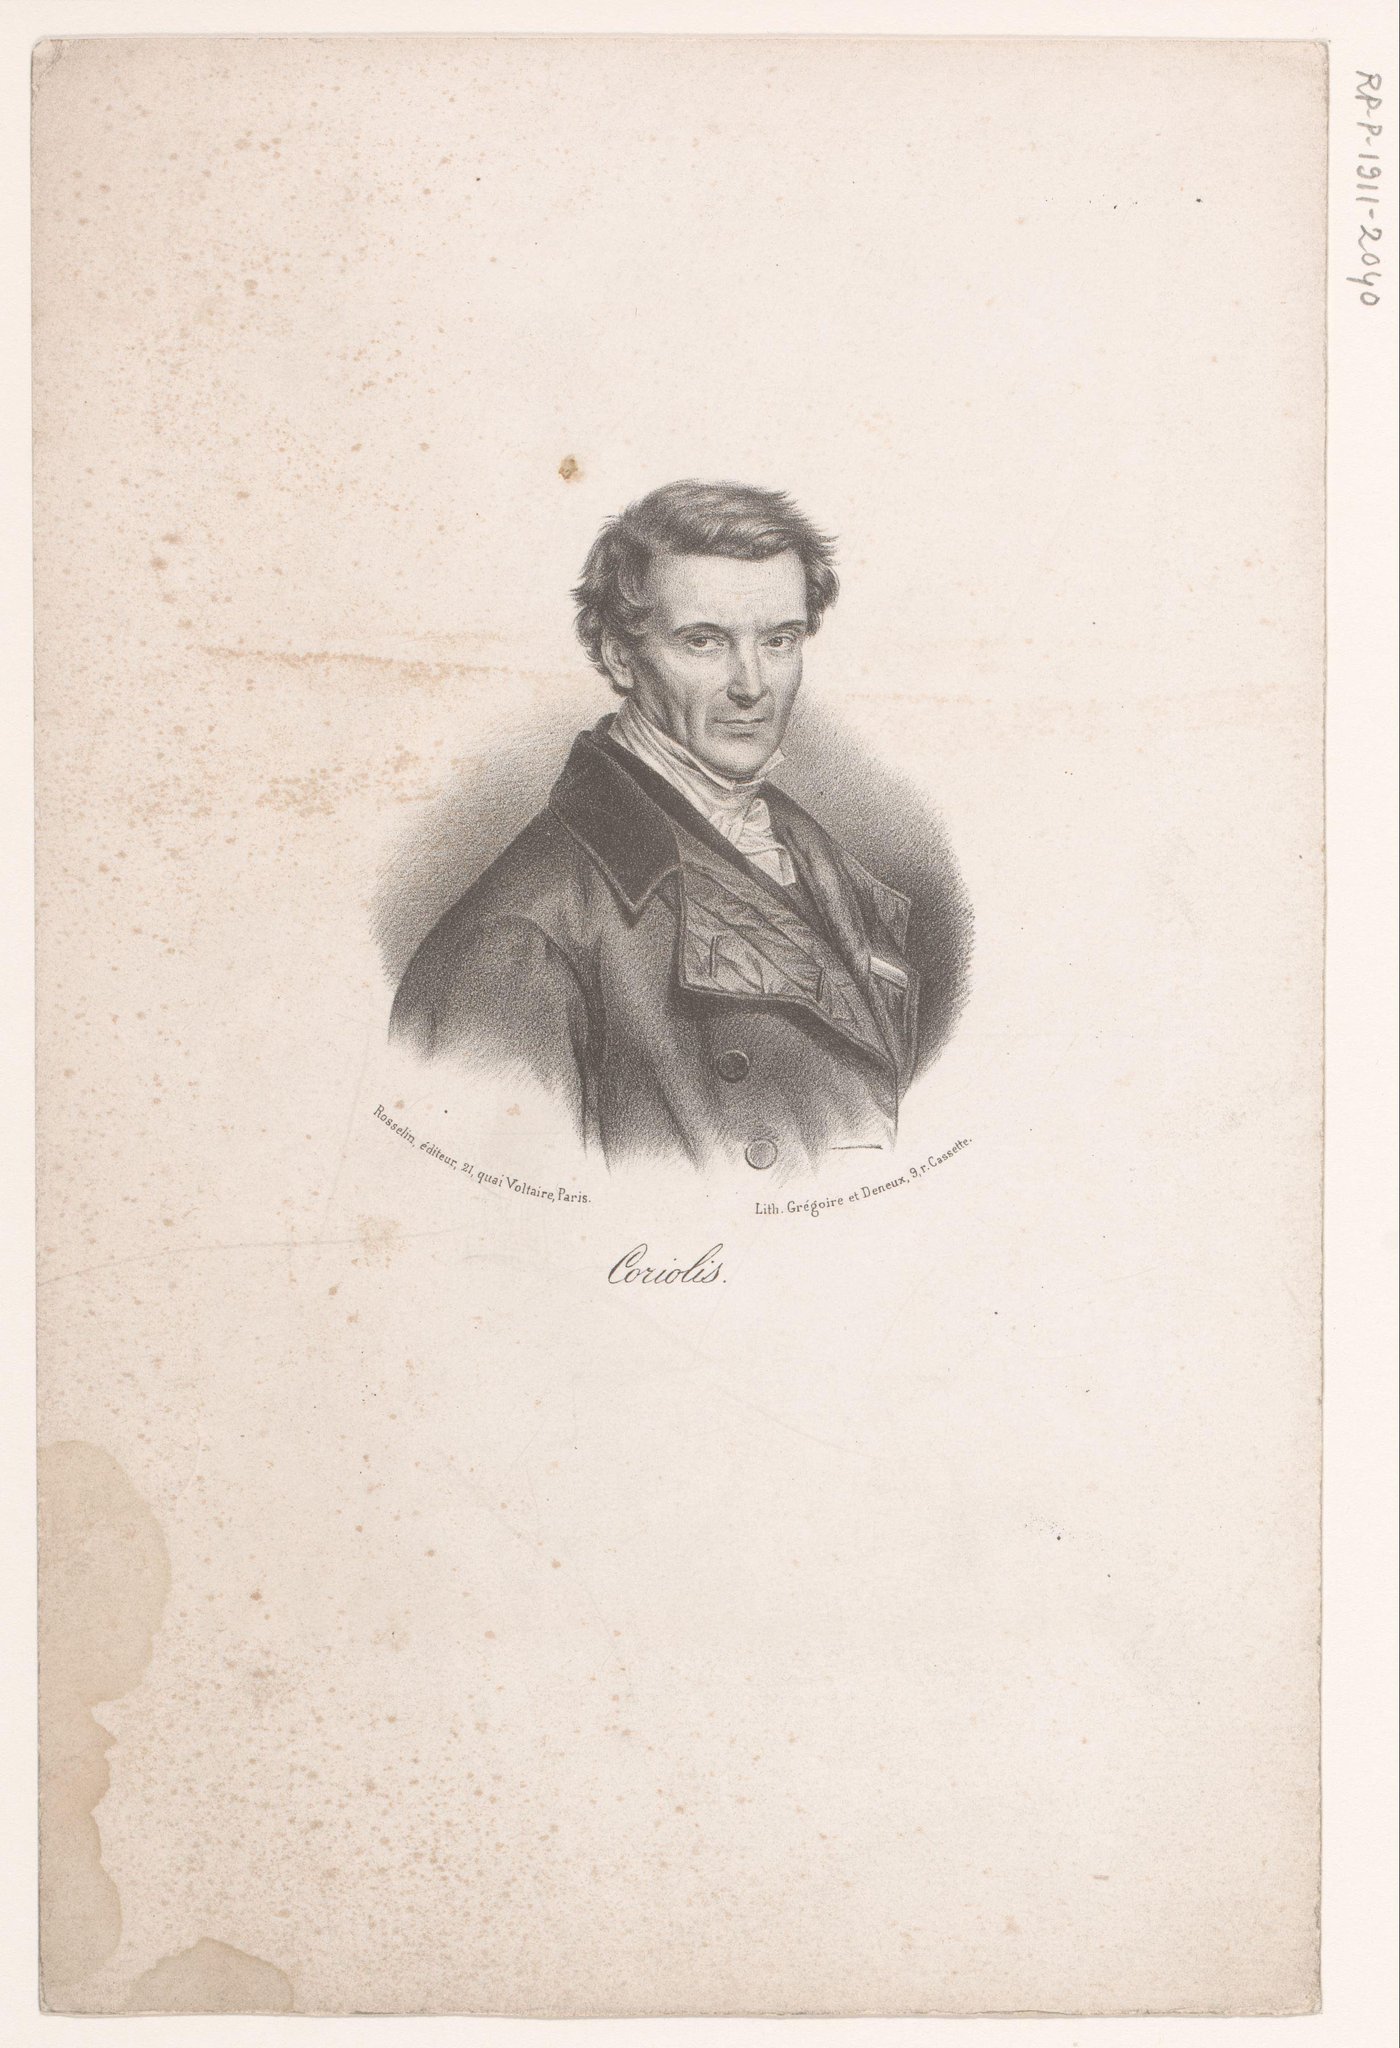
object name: print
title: Beroemde personen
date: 1844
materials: paper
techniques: lithograph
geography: paris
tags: paris, engineer, historical persons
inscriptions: collector's mark: Lugt 2228a